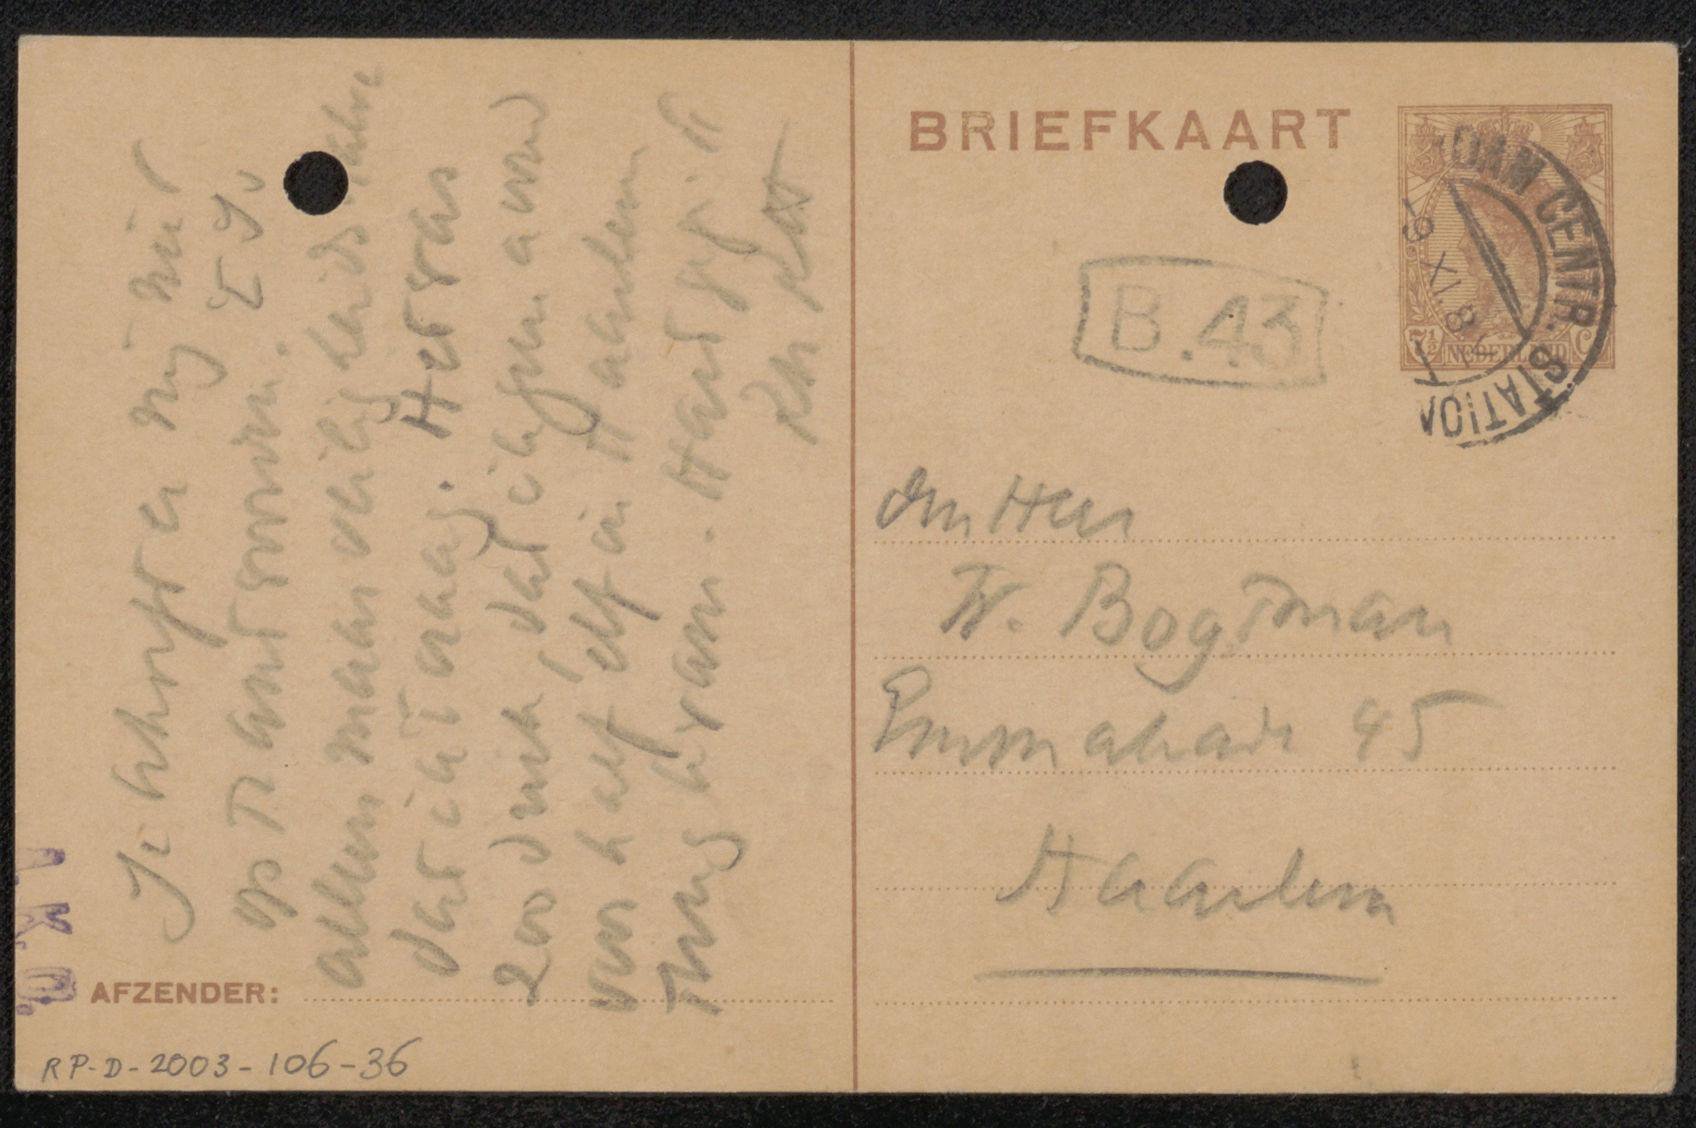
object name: postcard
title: Briefkaart aan Willem Bogtman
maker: richard nicolaüs roland holst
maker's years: 1868-1938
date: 1922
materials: cardboard, pencil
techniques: pen, writing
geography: amsterdam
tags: haarlem, willem bogtman, applied arts, arts and crafts; industrial design